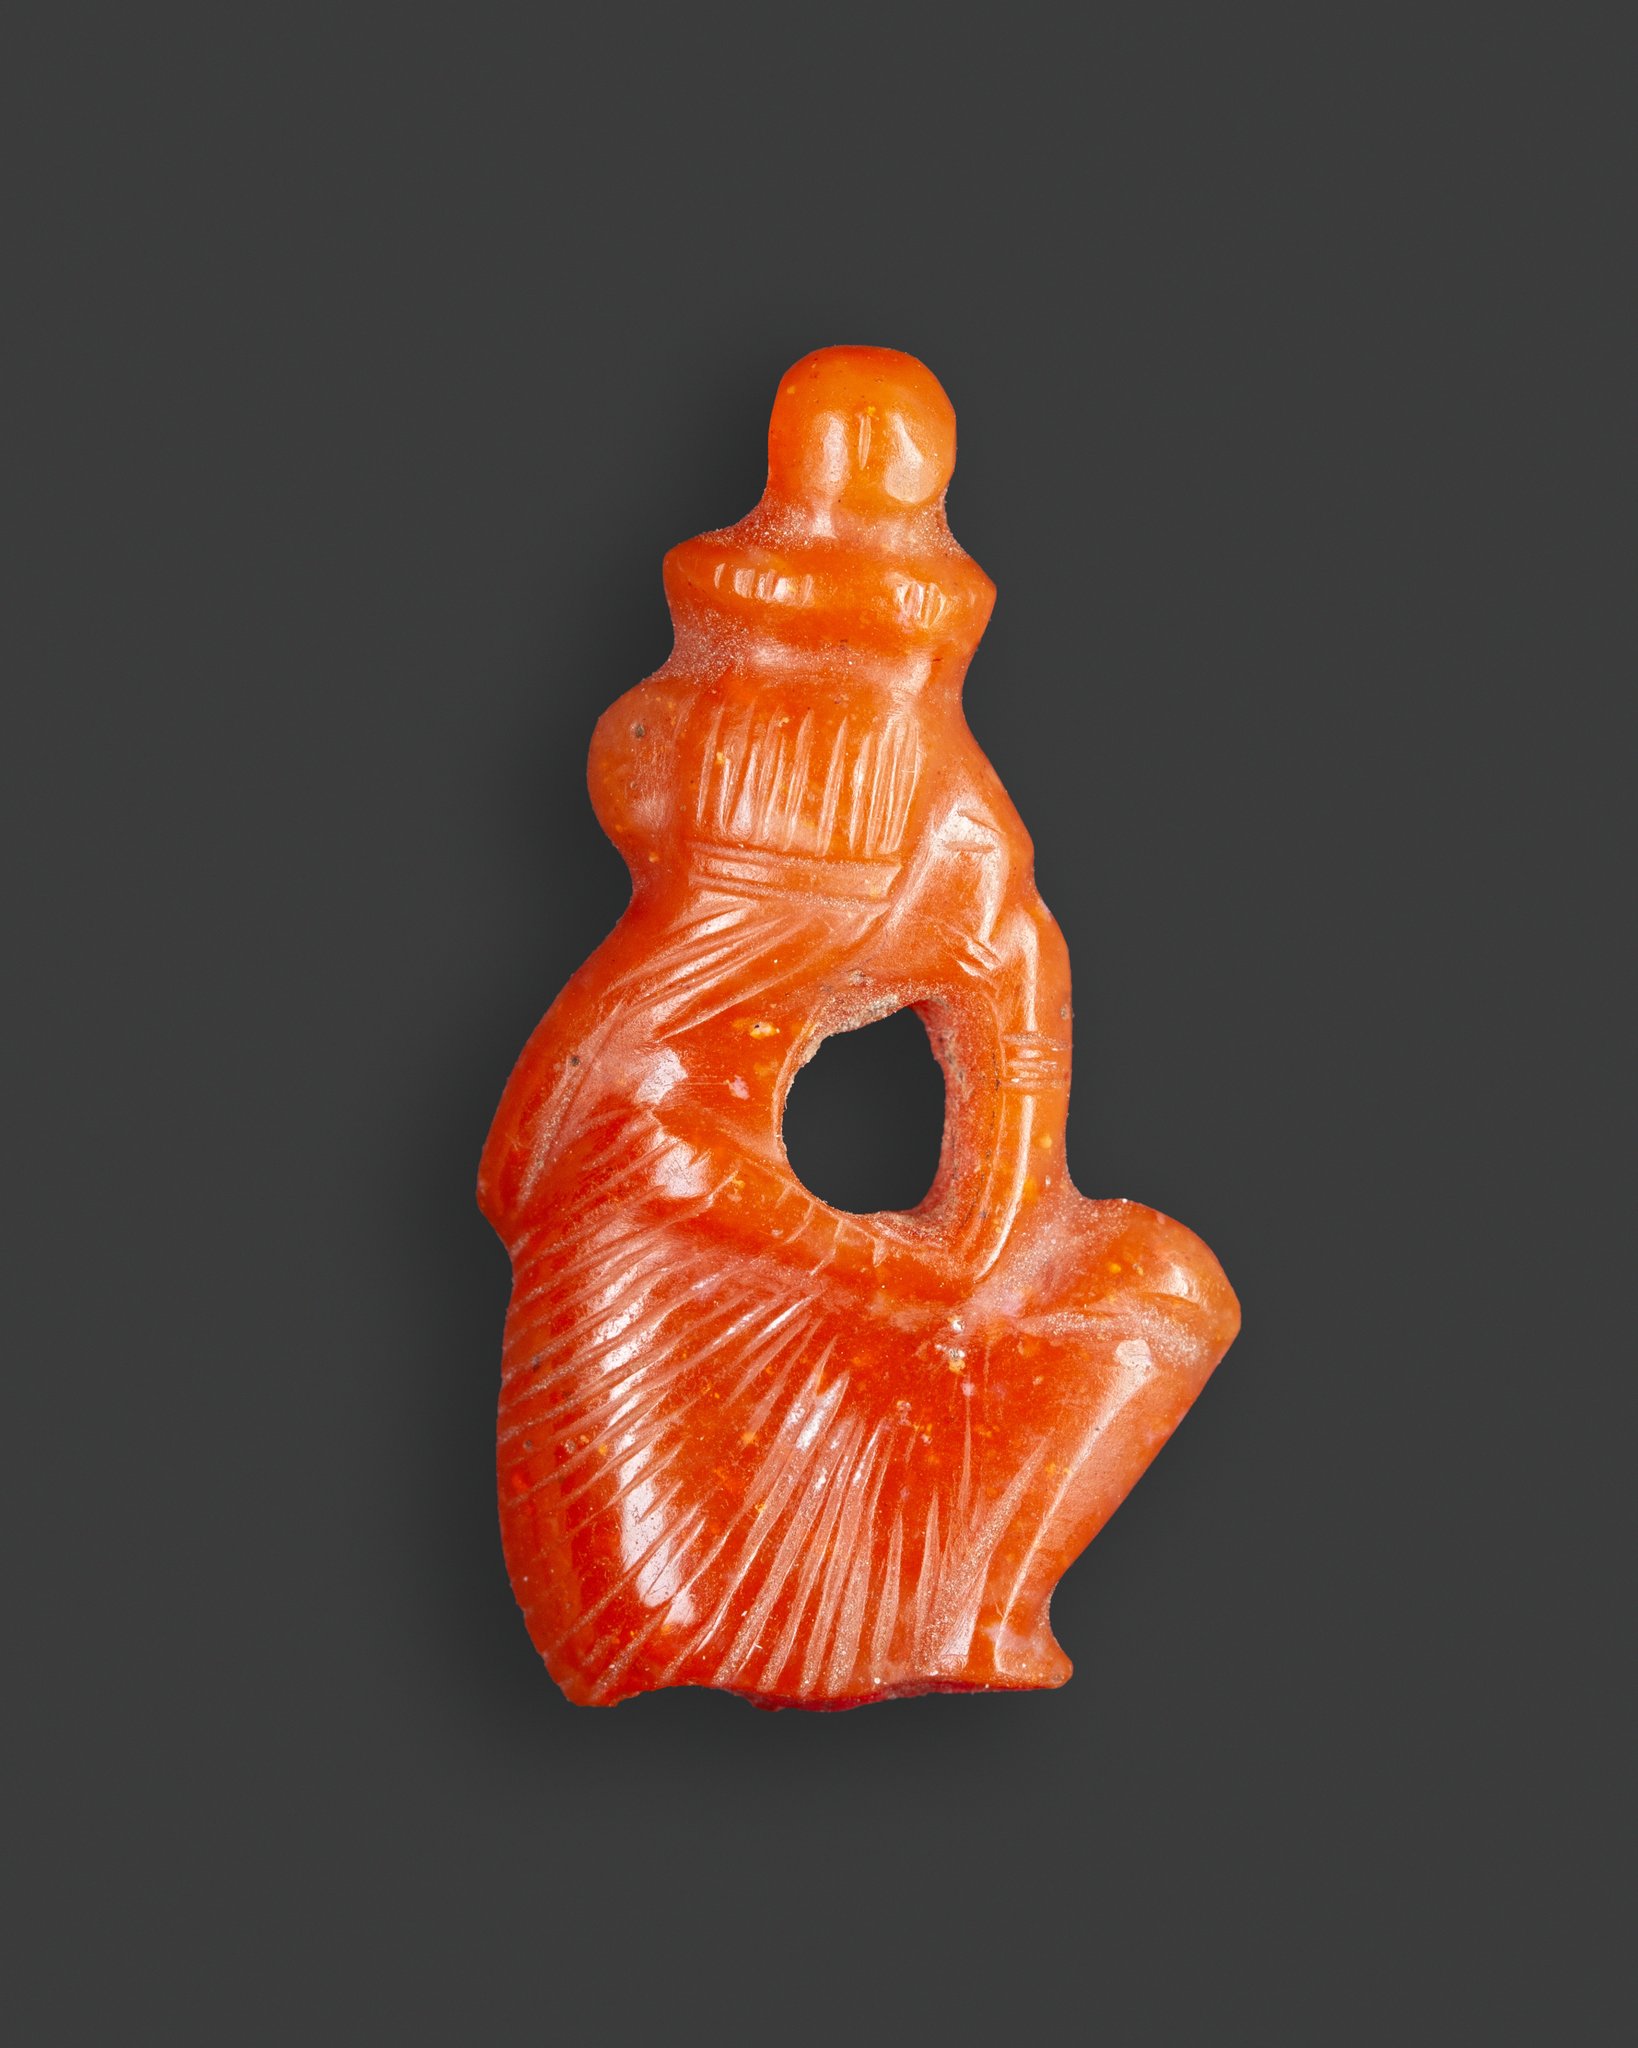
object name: amulet, squatting child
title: Amulet of a squatting royal female child with the name Nefertari Merimut on the underside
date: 1279-1213 BCE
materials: gemstone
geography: egypt